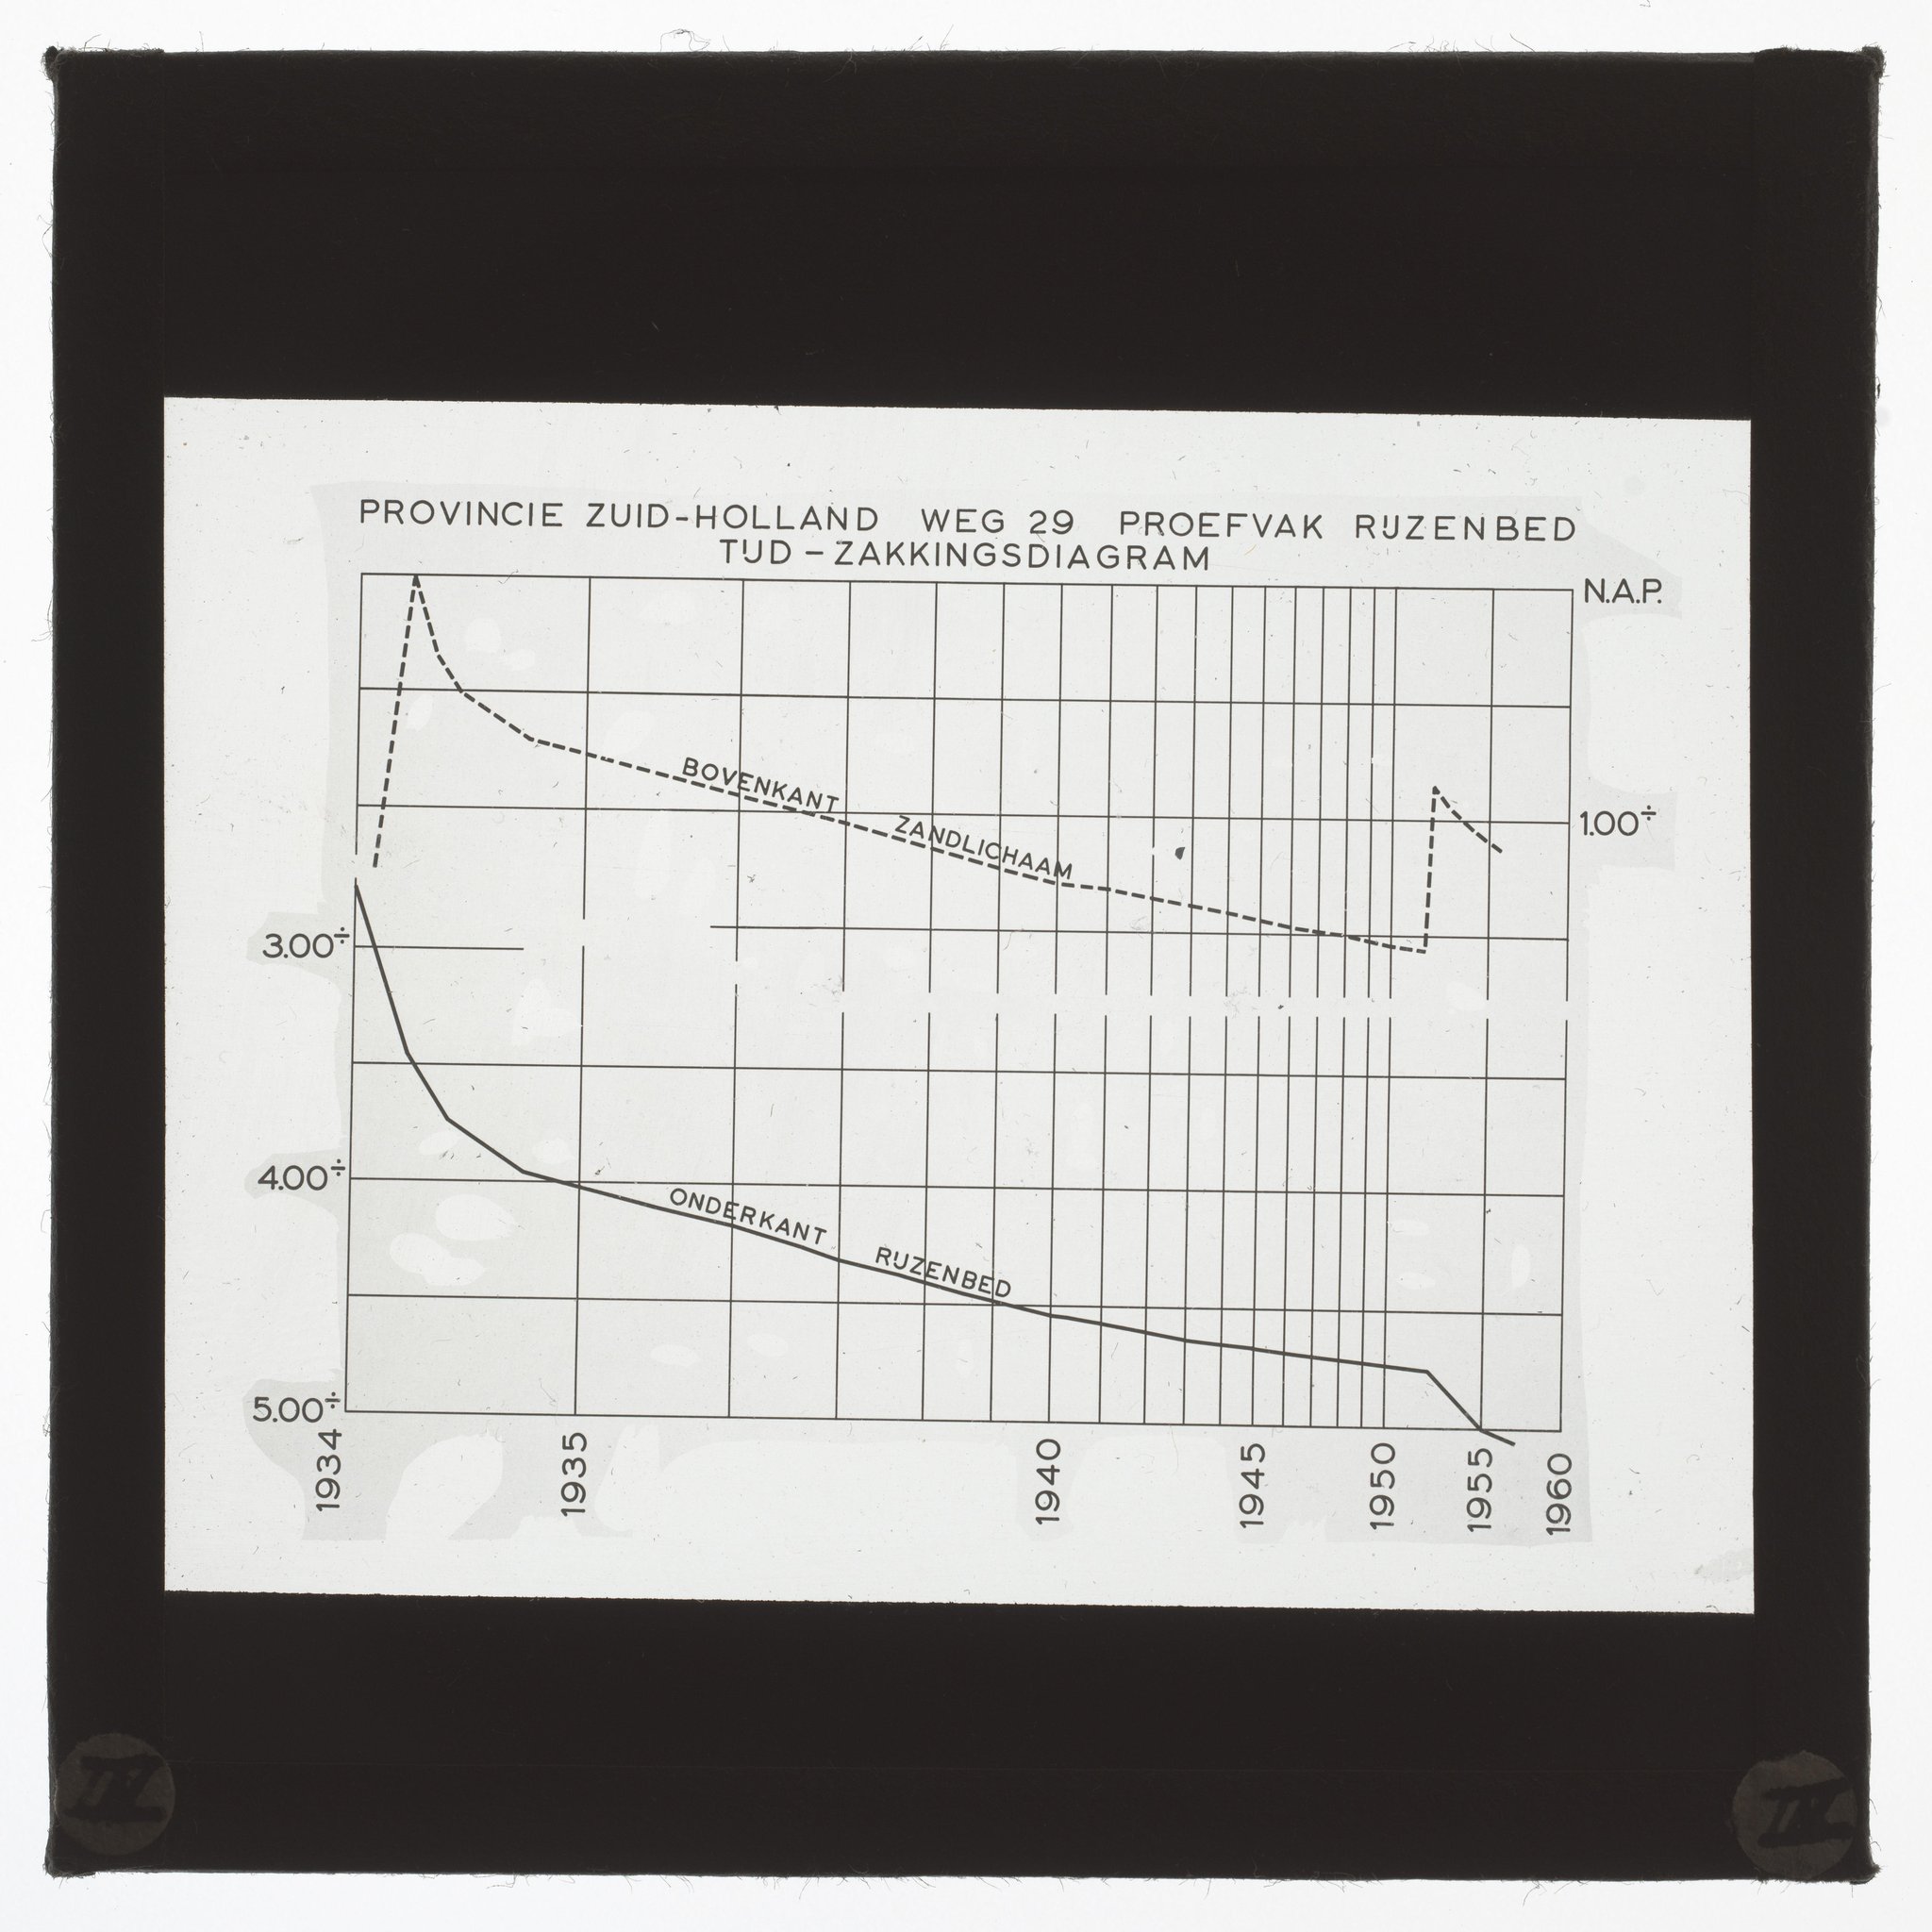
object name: photomechanical print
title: Diagram van verzakkingen onder een provinciale weg in Zuid-Holland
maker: Anonymous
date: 1956-1960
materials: glass, paper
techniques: printing block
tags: statistic diagram, graph; pictorial chart, etc.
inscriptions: number: ‘IV’